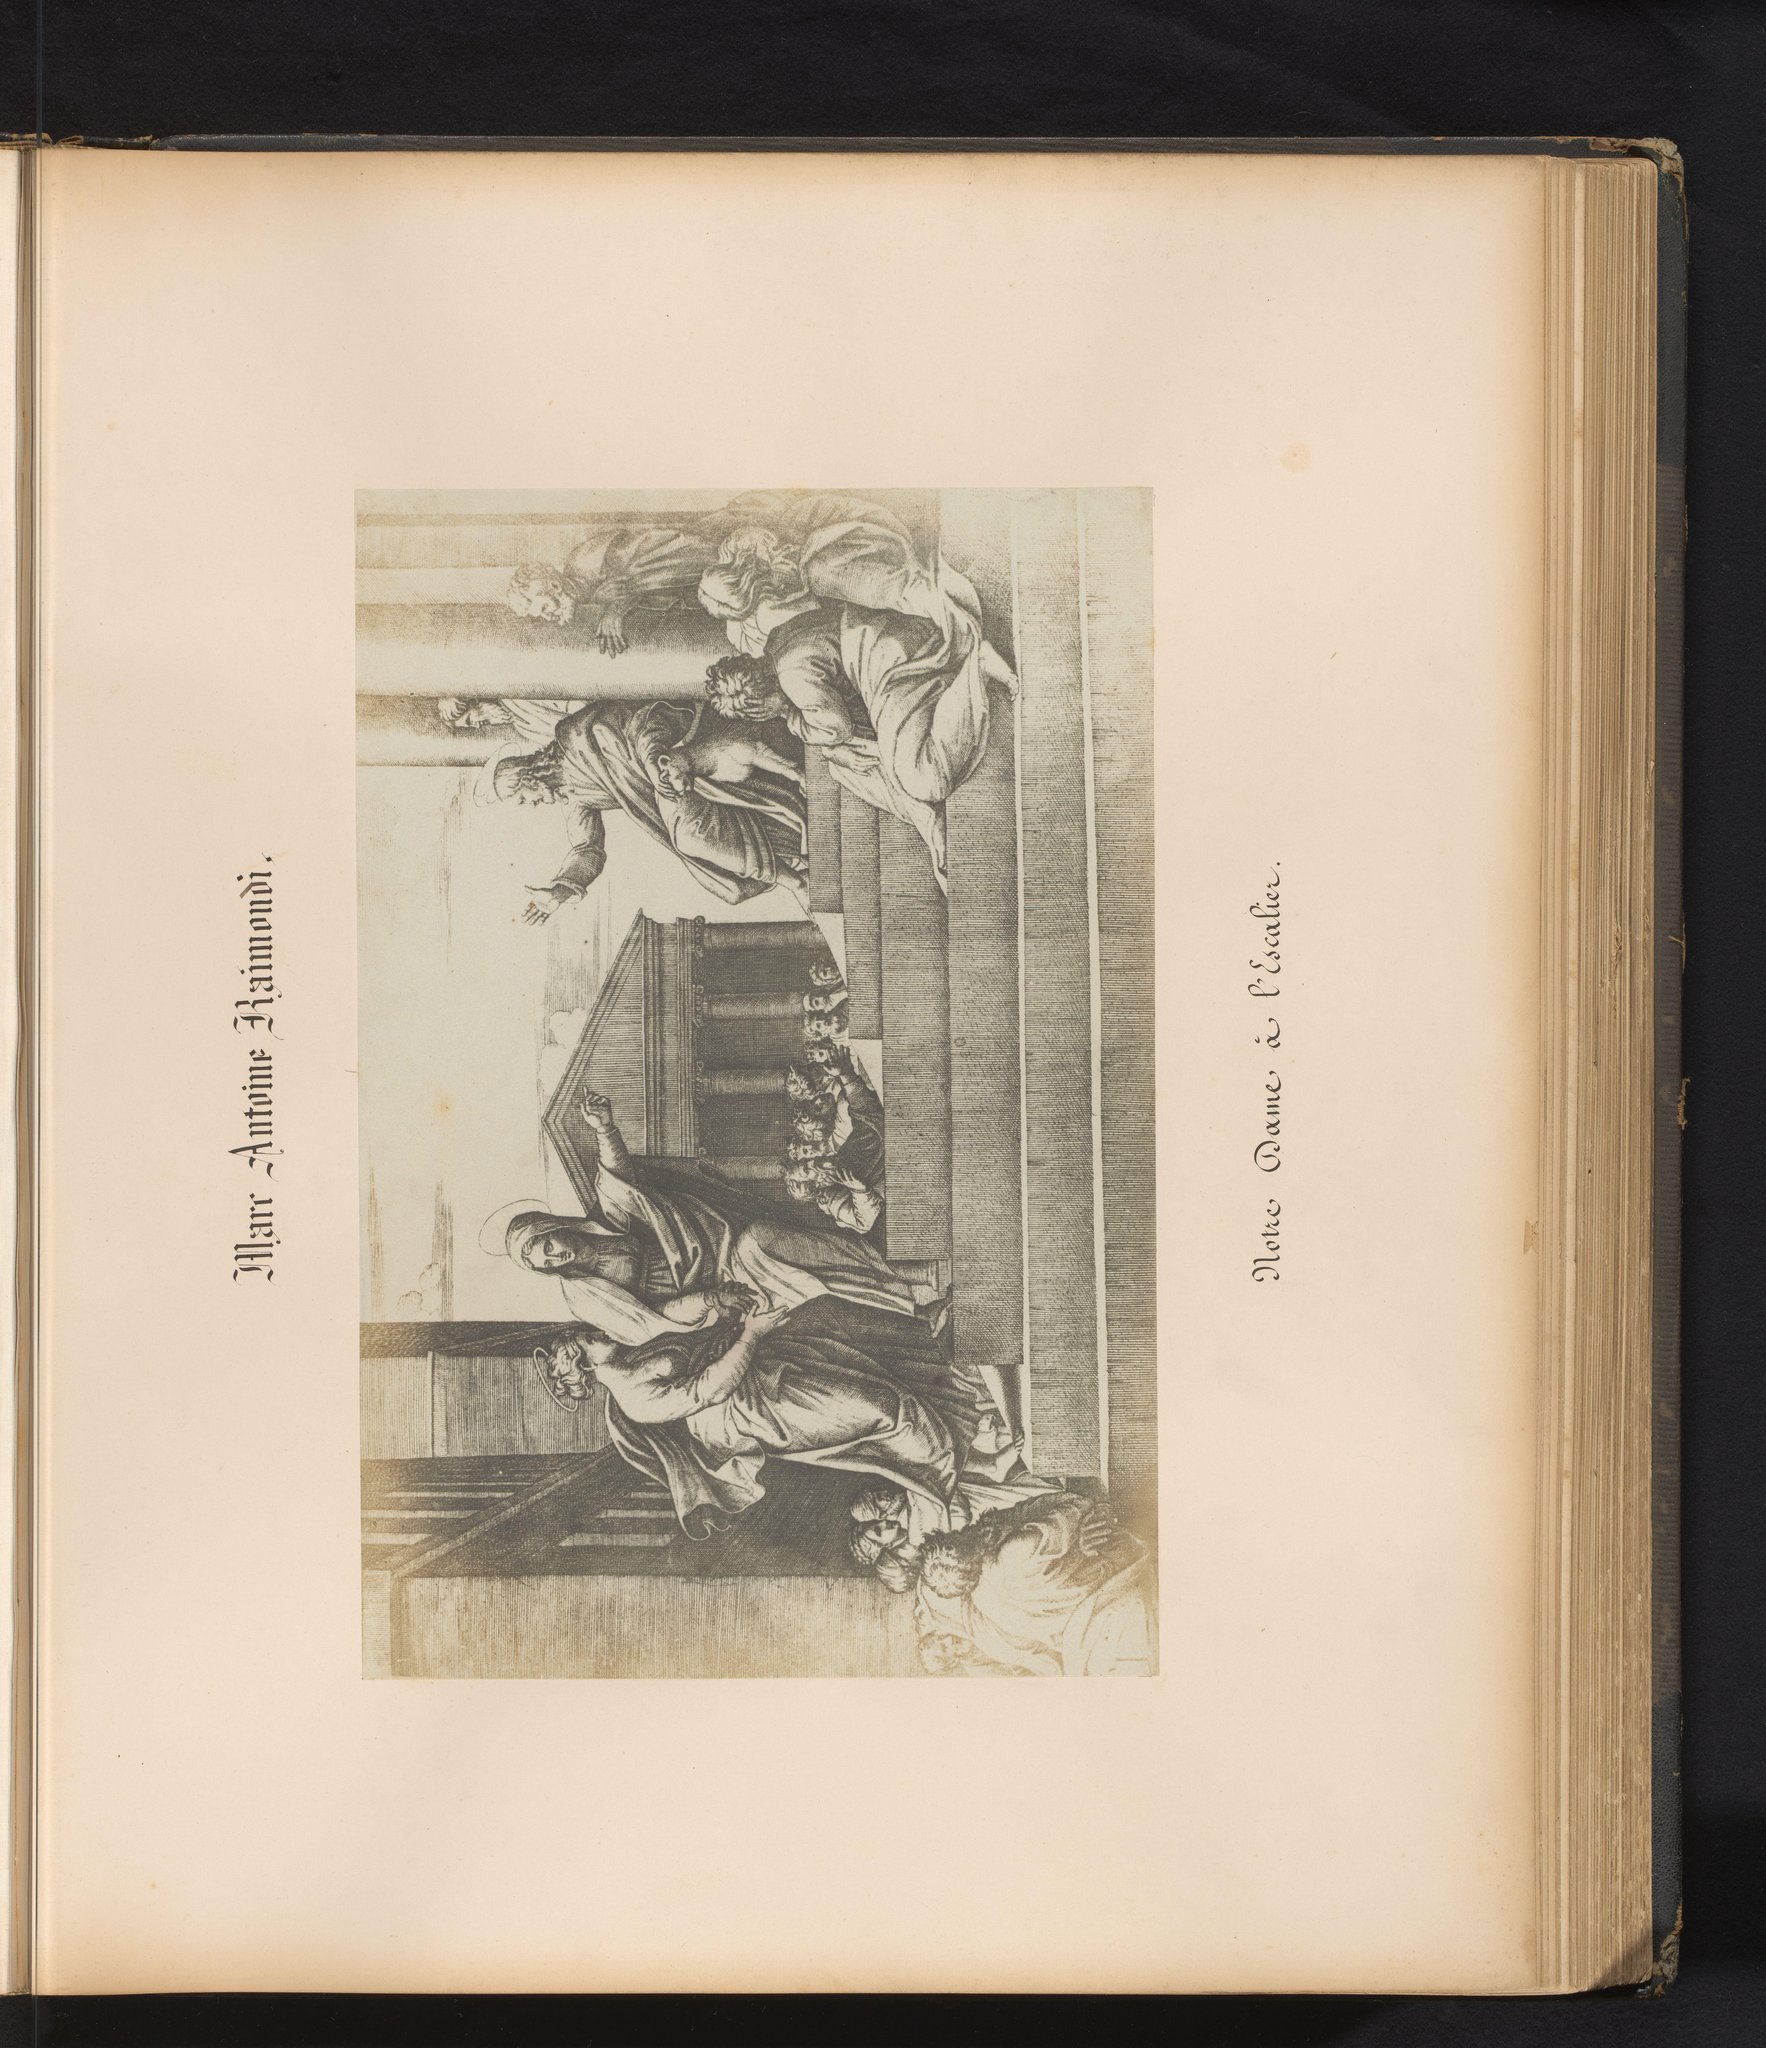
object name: photograph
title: Fotoreproductie van een gravure van Maria die de tempel betreedt door Marcantonio Raimondi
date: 1848-1853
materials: photographic support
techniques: salted paper print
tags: dedication (or presentation) of mary in the temple: she ascends the steps and is received by the high priest